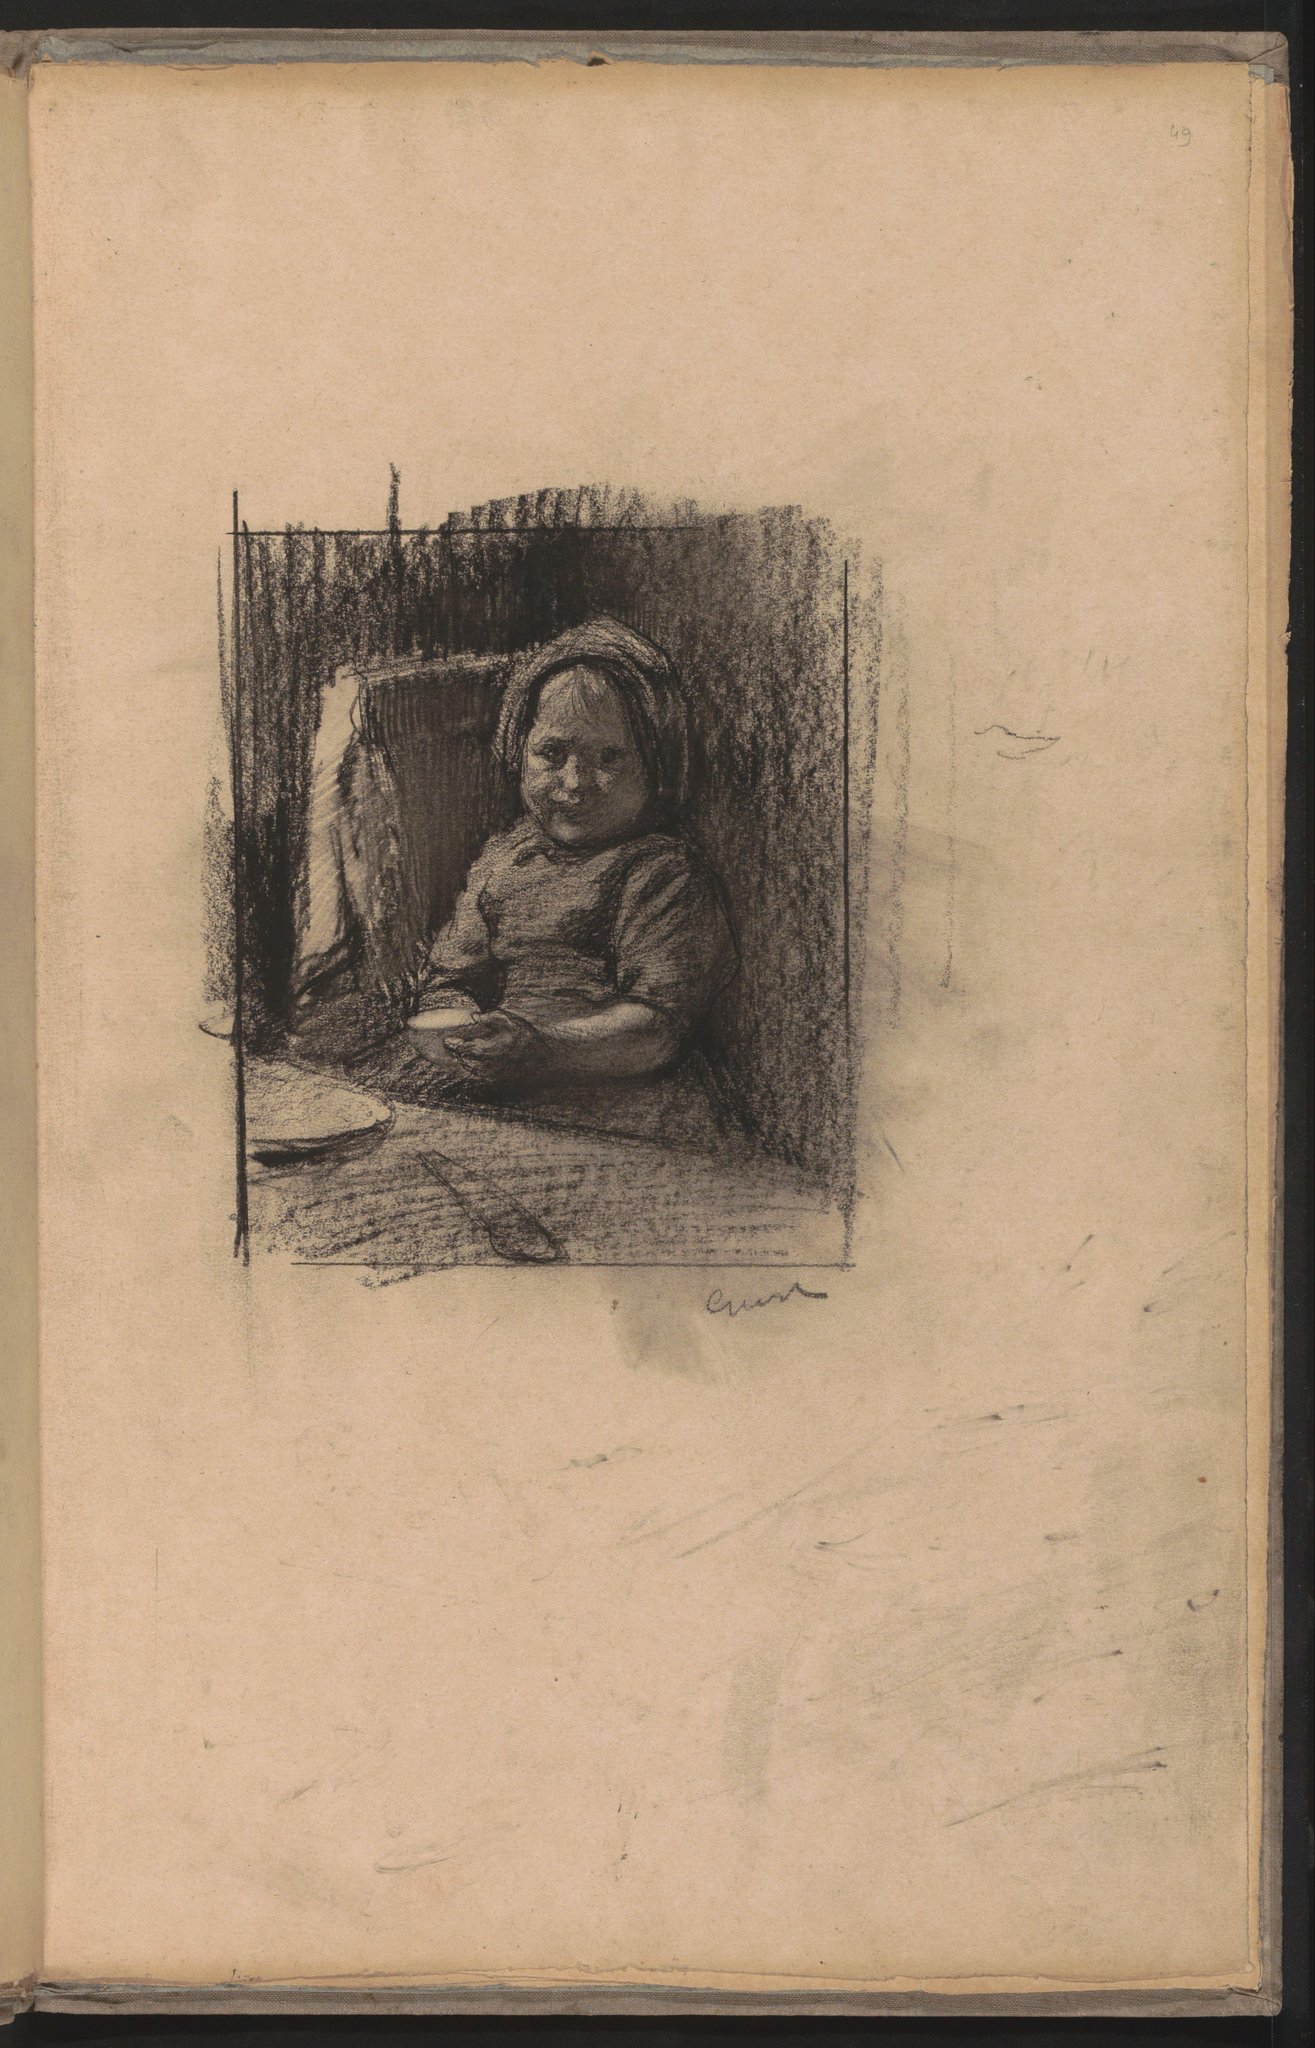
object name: sketchbook leaf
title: Boerenmeisje met nap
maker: willem witsen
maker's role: draughtsman, painter, print maker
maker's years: 1860-1923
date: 1886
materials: chalk, paper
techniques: stumping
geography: ewijkshoeve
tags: girl (child between toddler and youth) (+ sitting), table, drinking-vessels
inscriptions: annotation: ‘Geert[?]’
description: Ze zit aan tafel. Pagina 49 uit een schetsboek met 38 bladen betekend rond de Ewijkshoeve.